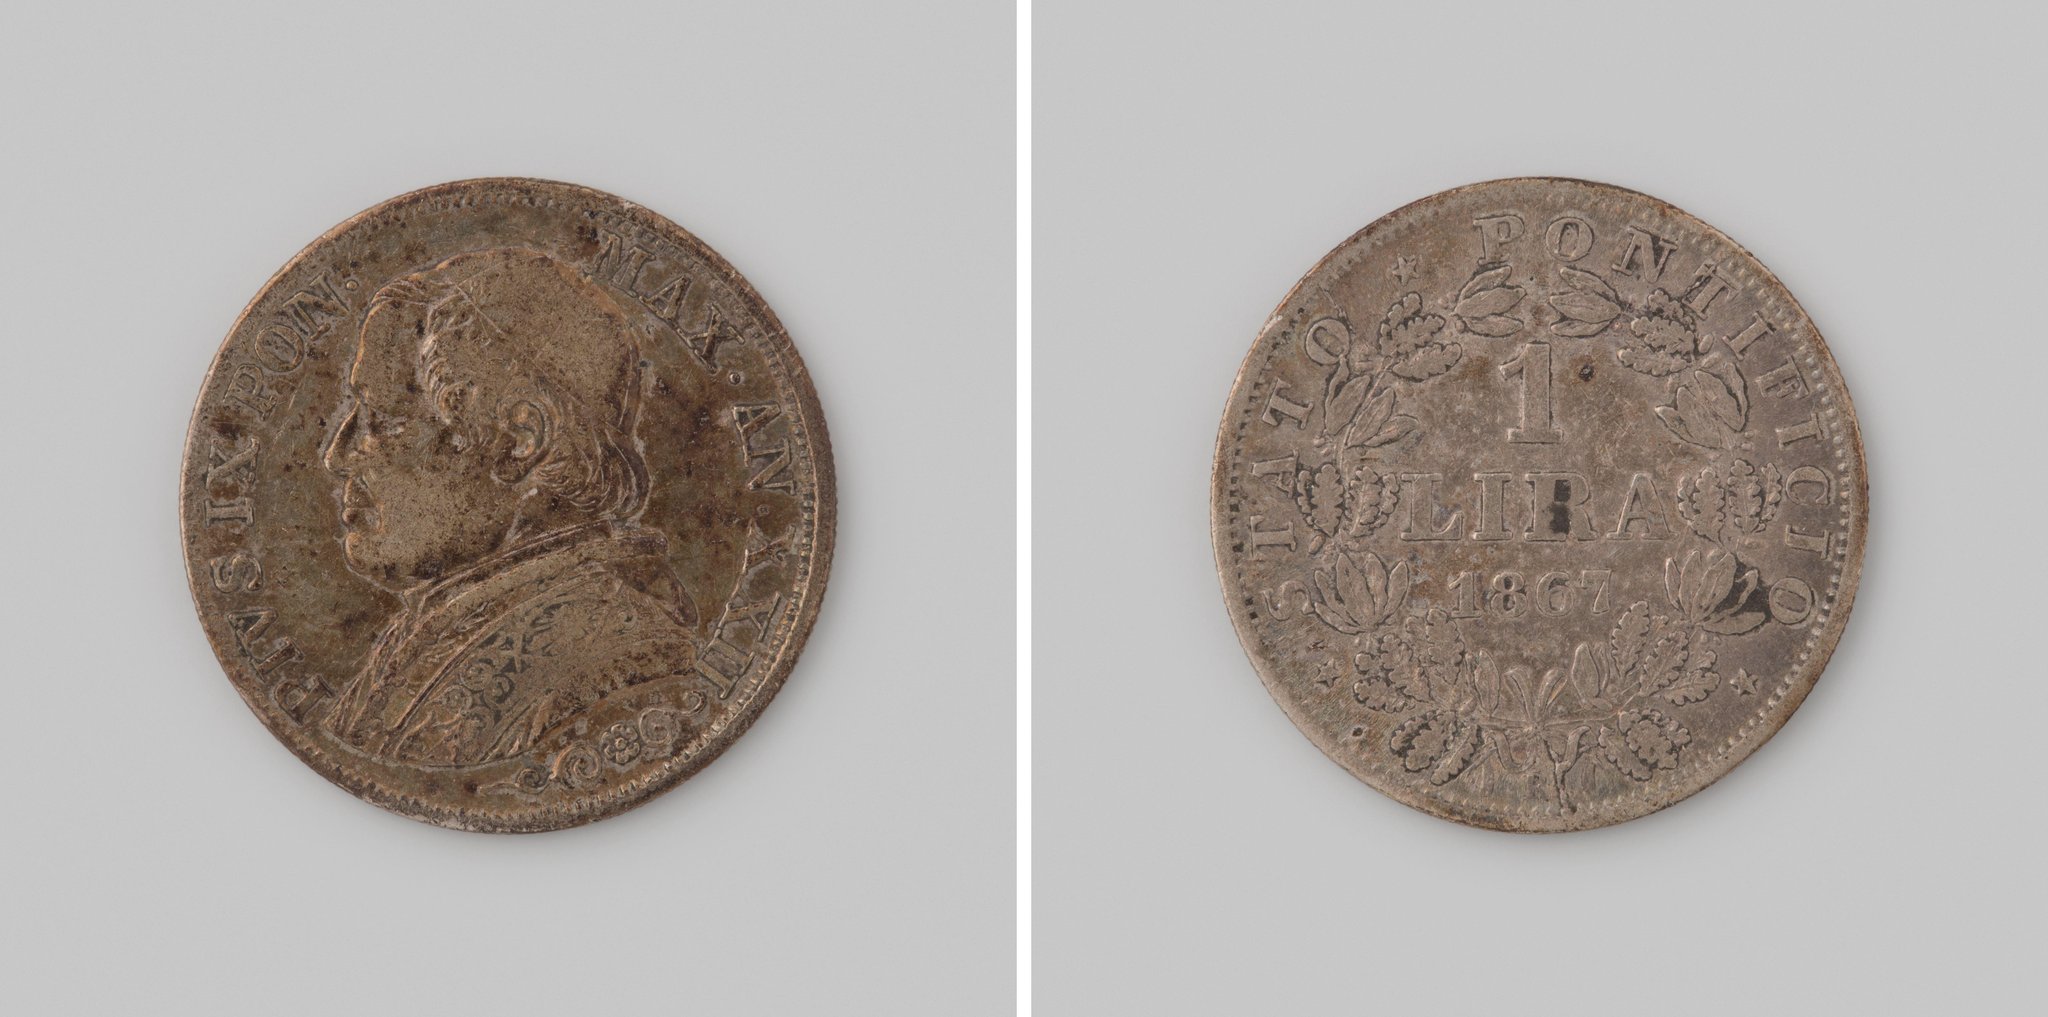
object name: coin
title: Lira uit de Kerkelijke Staat van paus Pius IX, 1867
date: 1867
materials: silver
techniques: striking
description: Zilveren munt. Voorzijde: portret van de paus naar links. In omschrift jaartal: An XXII = 1867. Keerzijde: binnen twee samengebonden takken waarde-aanduiding in twee regels, waaronder jaartal. Onderaan letter R. Kartelrand.